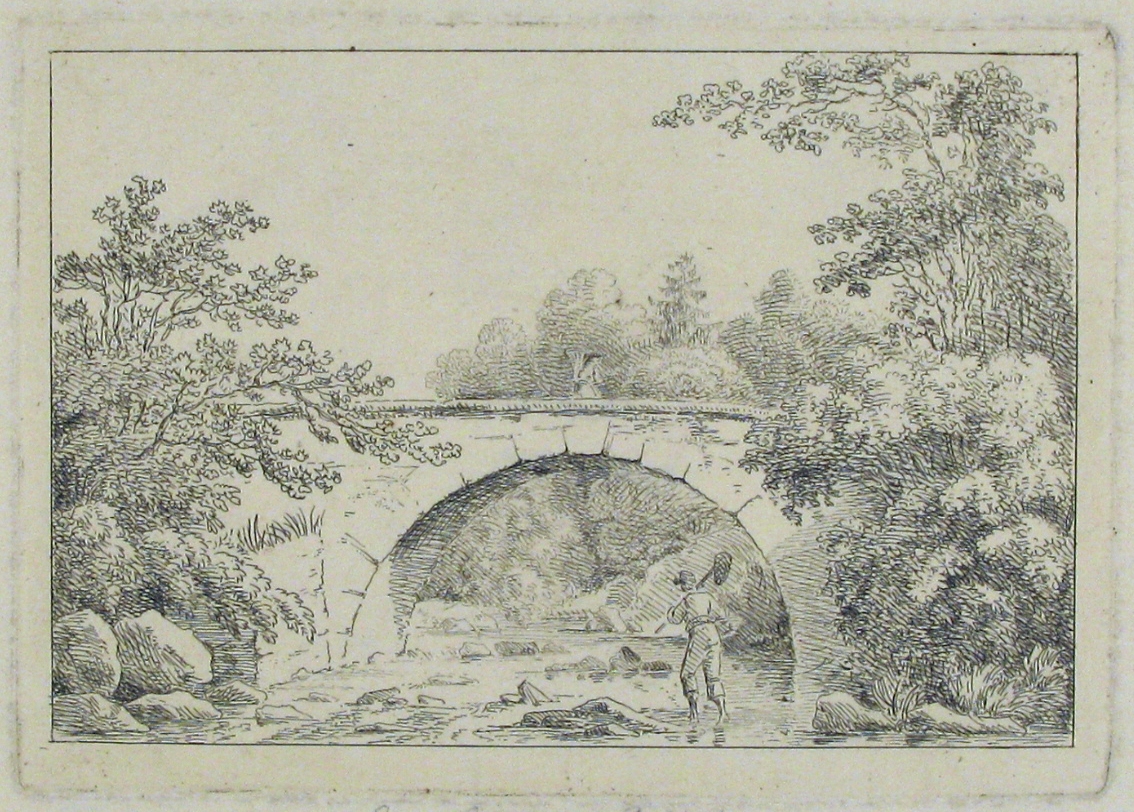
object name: print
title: Landscape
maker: françois jean sablet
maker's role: artist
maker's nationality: french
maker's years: 1745-1819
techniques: etching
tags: human figures,bridges,canals